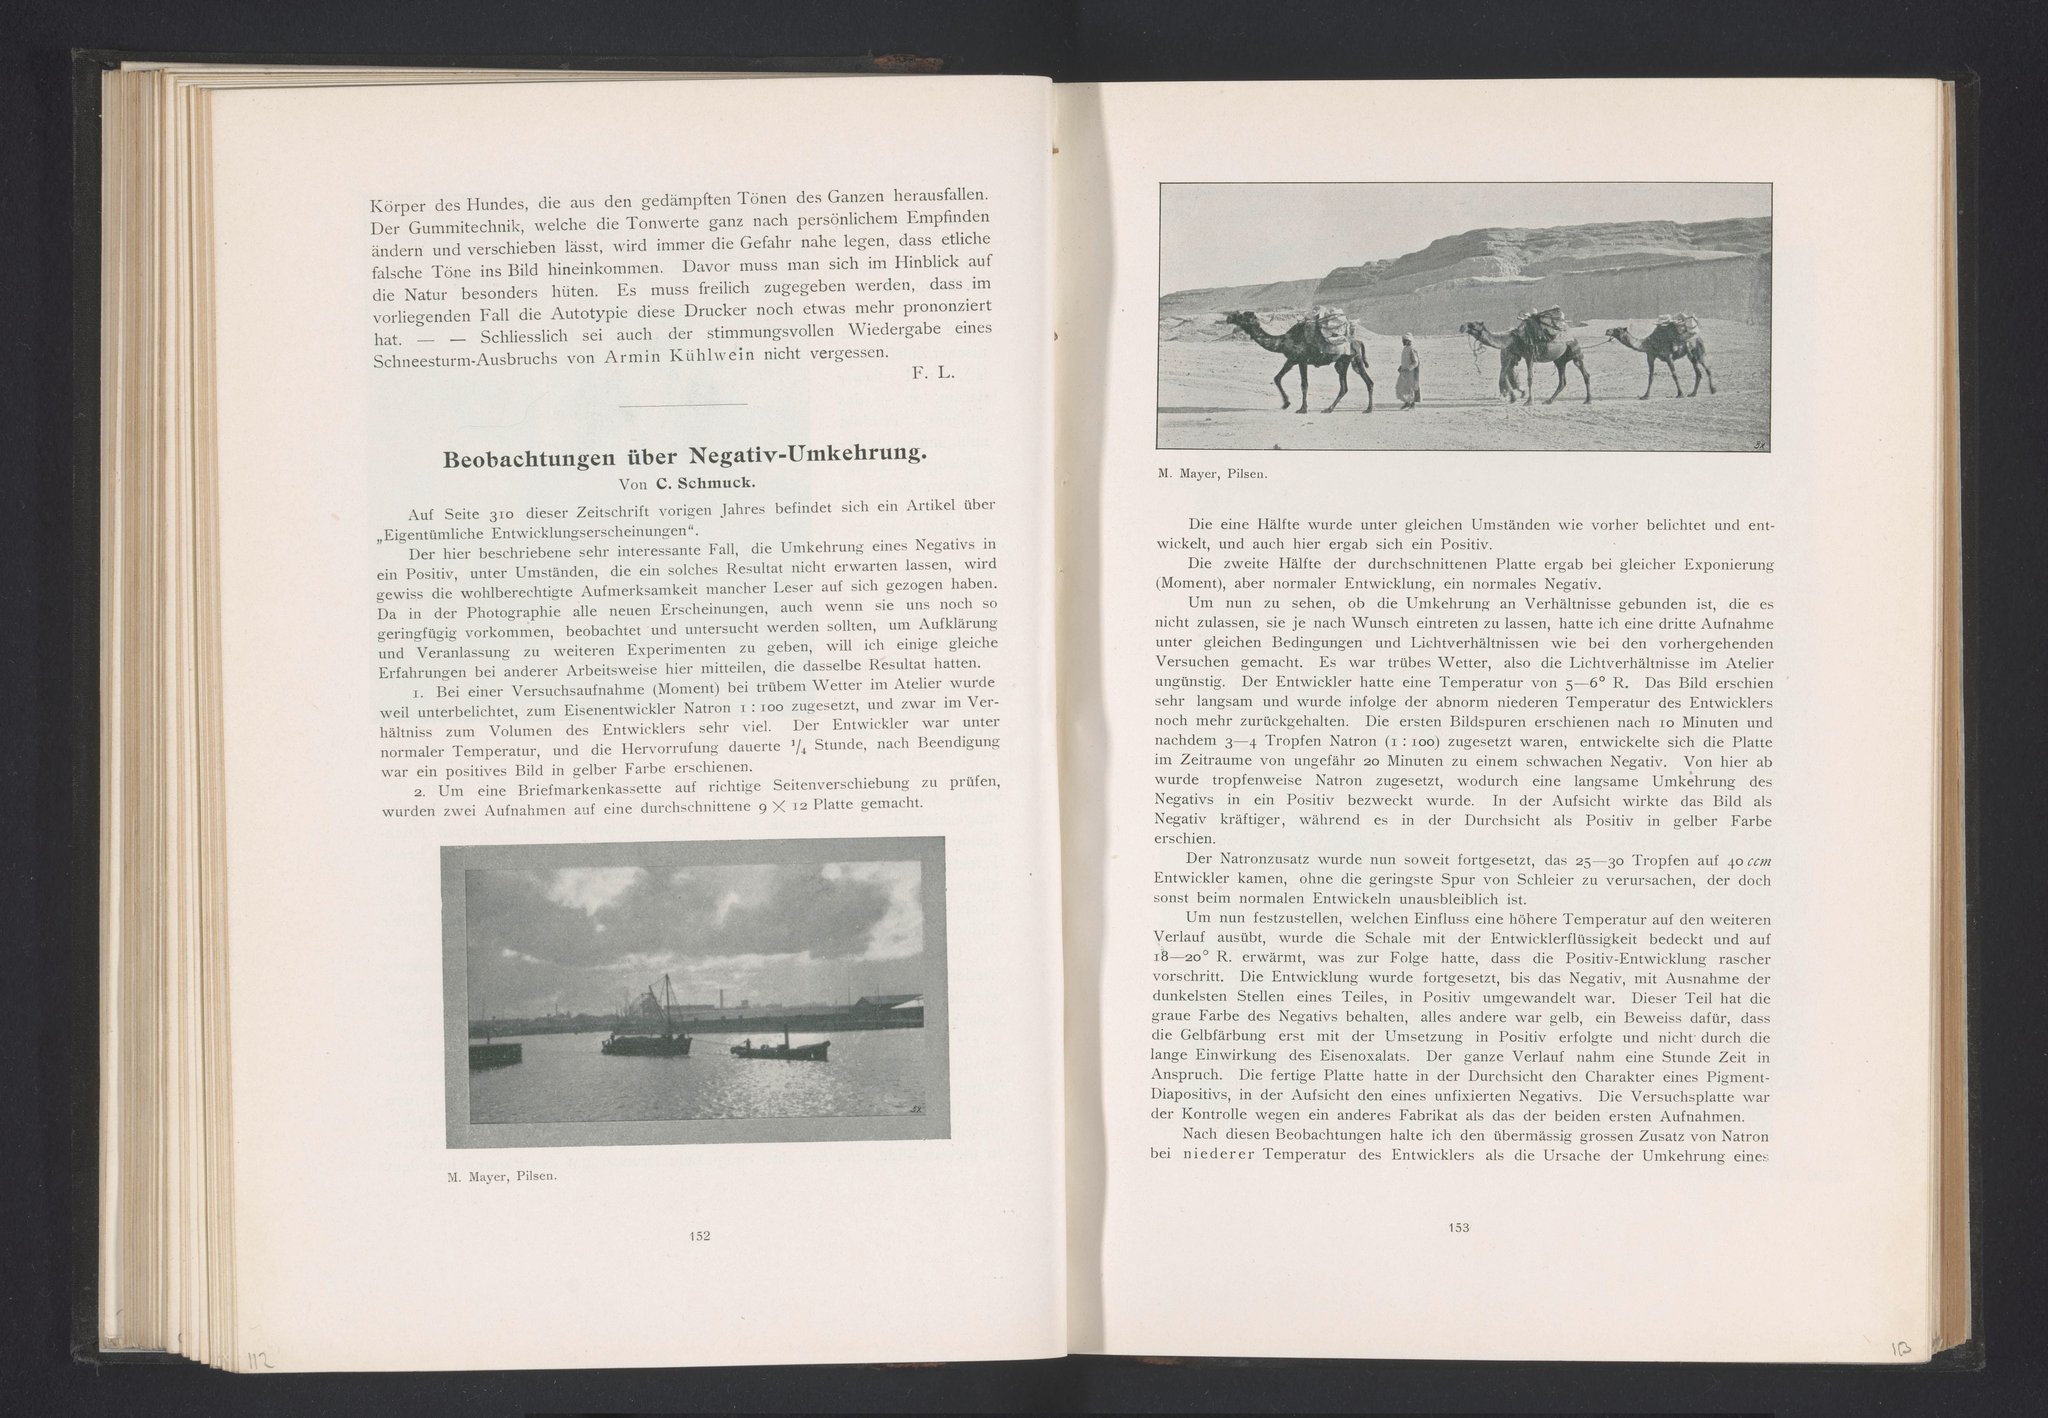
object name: photomechanical print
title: Gezicht op kamelen in de woestijn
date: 1898-1903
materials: paper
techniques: autotype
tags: hoofed animals: camel, desert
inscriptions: monogram: ‘BX’